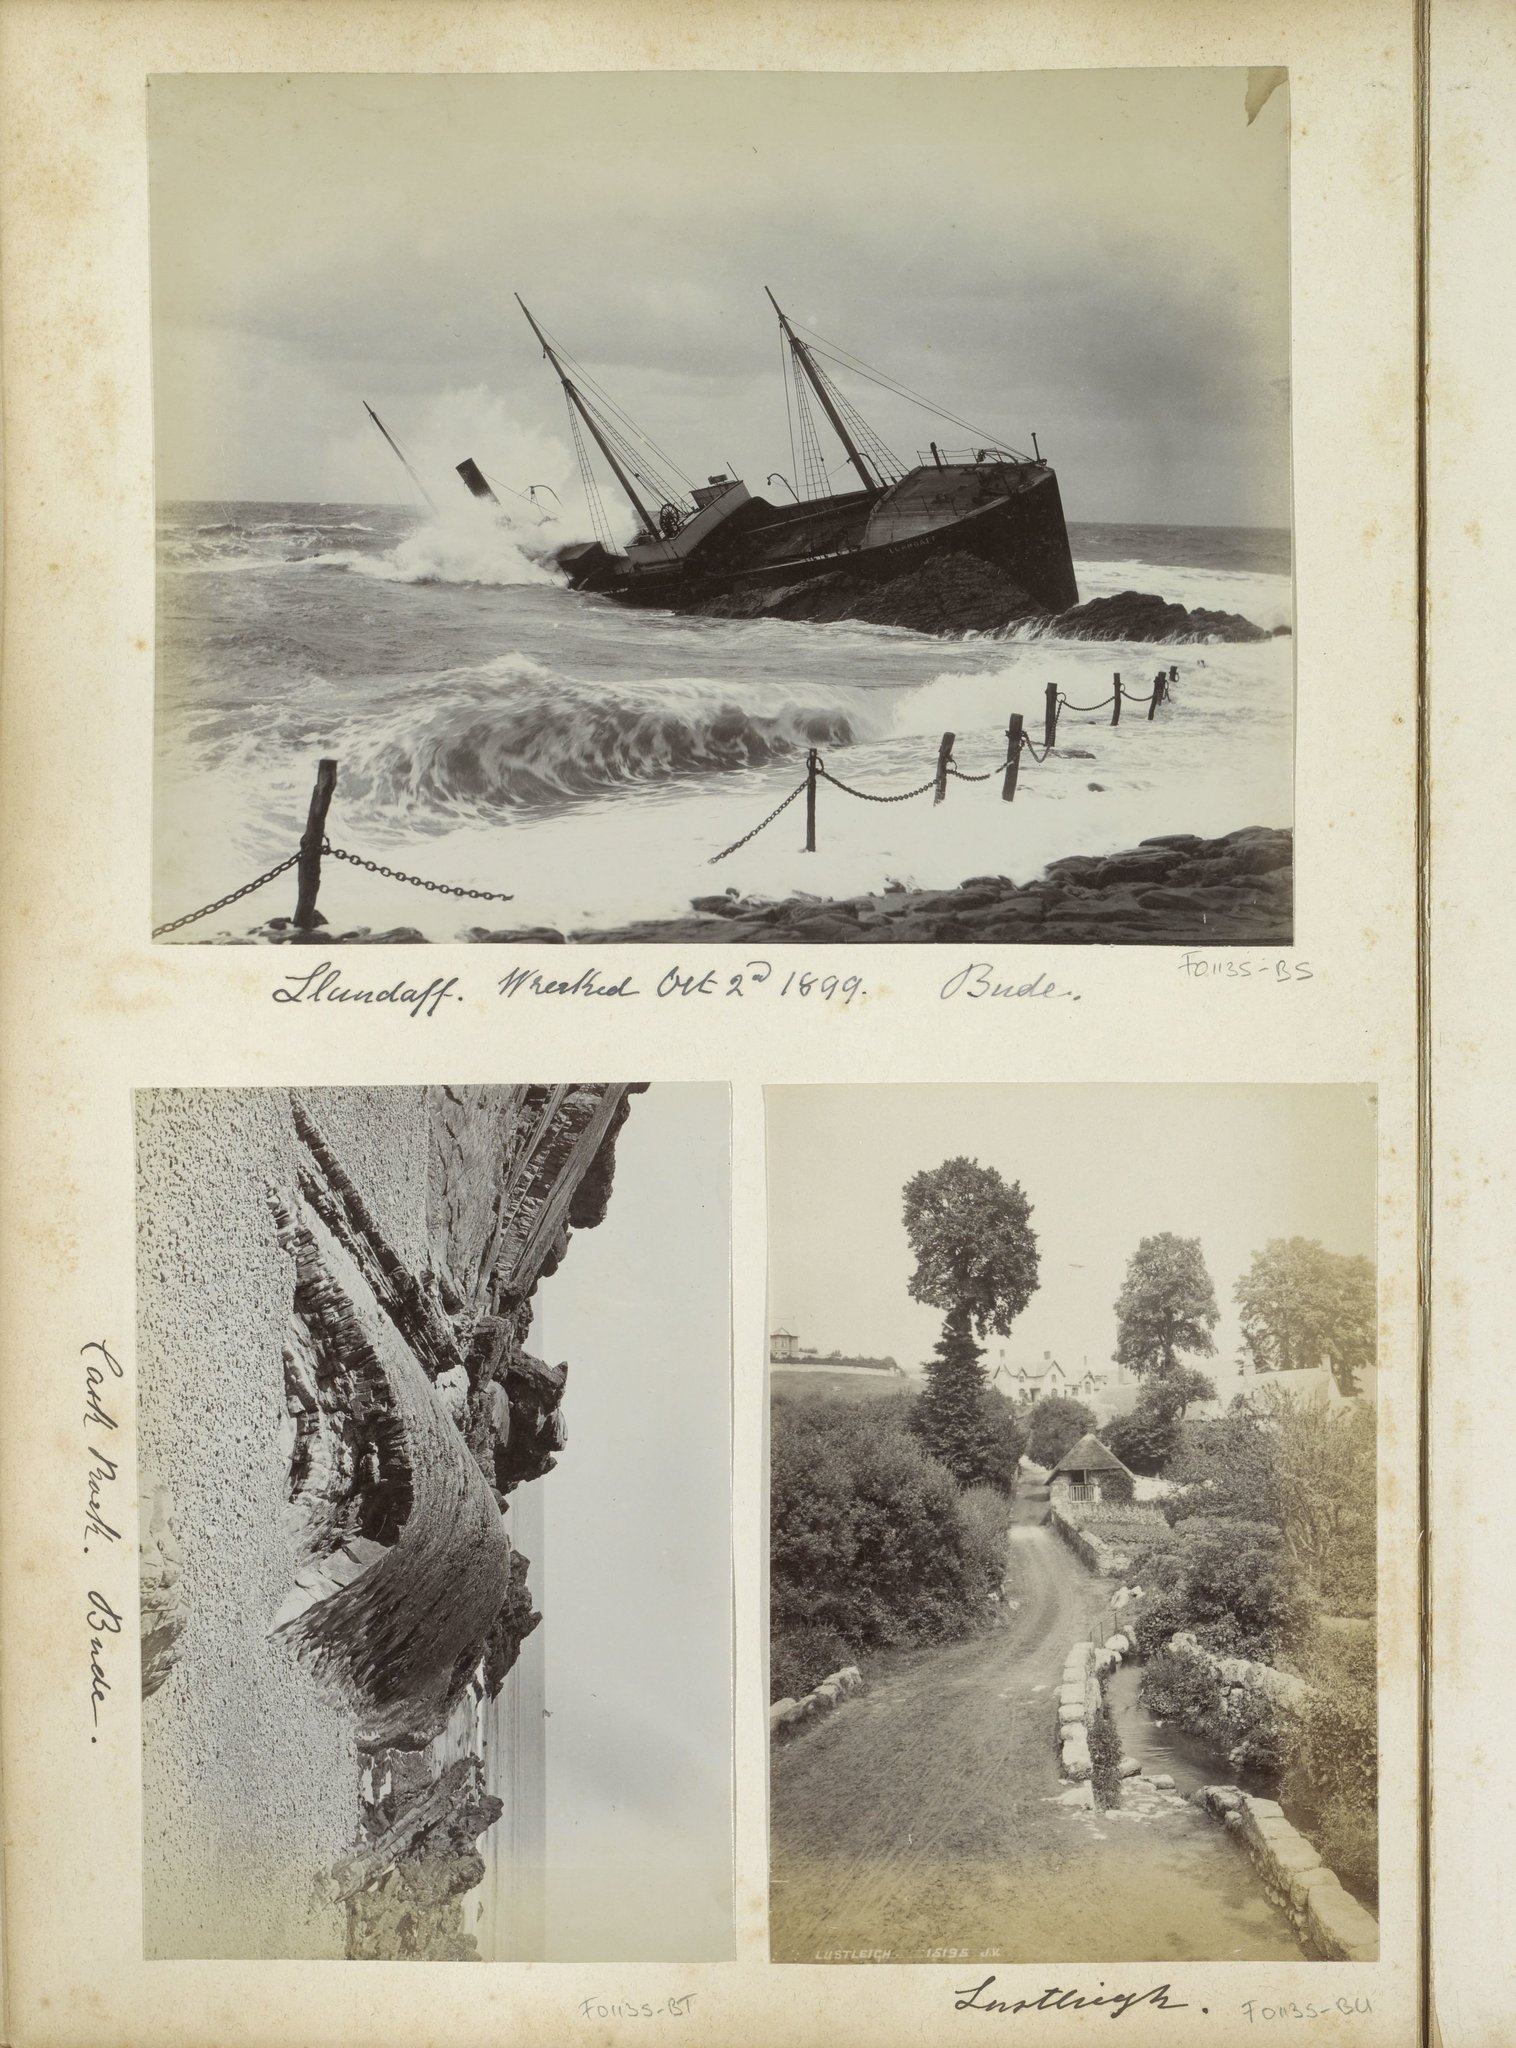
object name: photograph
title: Wrak van de Llandaff voor de kust van Bude (vergaan 2 oktober 1899)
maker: Anonymous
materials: paper, photographic support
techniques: daylight paper print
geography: bude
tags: wreck ashore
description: Onderdeel van Reisalbum met foto's van bezienswaardigheden in Engeland en Frankrijk.